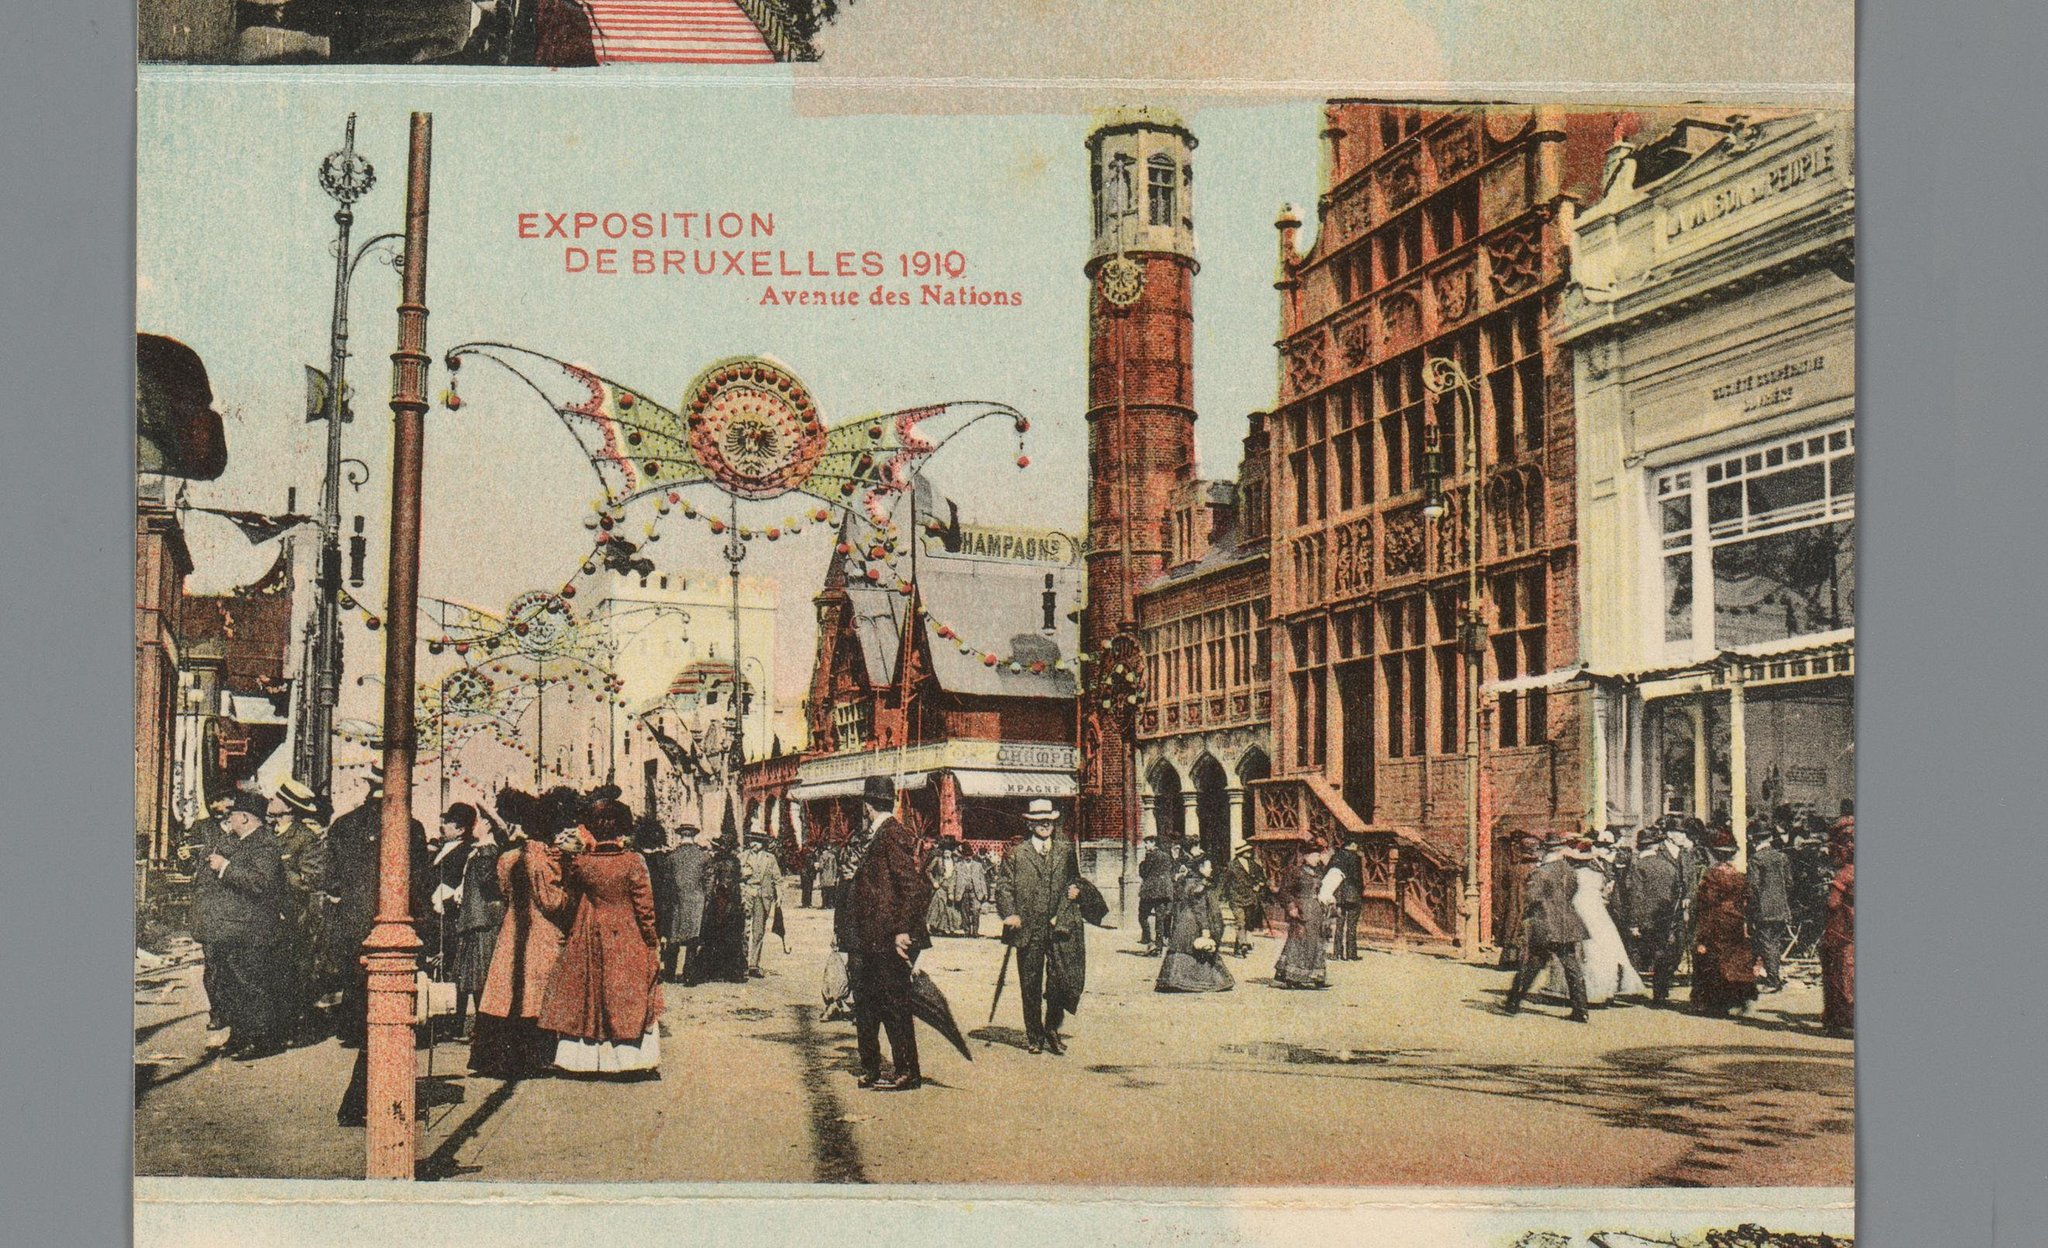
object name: photomechanical print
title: Exposition de Bruxelles 1910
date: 1910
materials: cardboard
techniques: photograph, lithograph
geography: brussels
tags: world fair, world exhibition, city-view, and landscape with man-made constructions (+ city(-scape) with figures, staffage), brussels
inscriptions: date